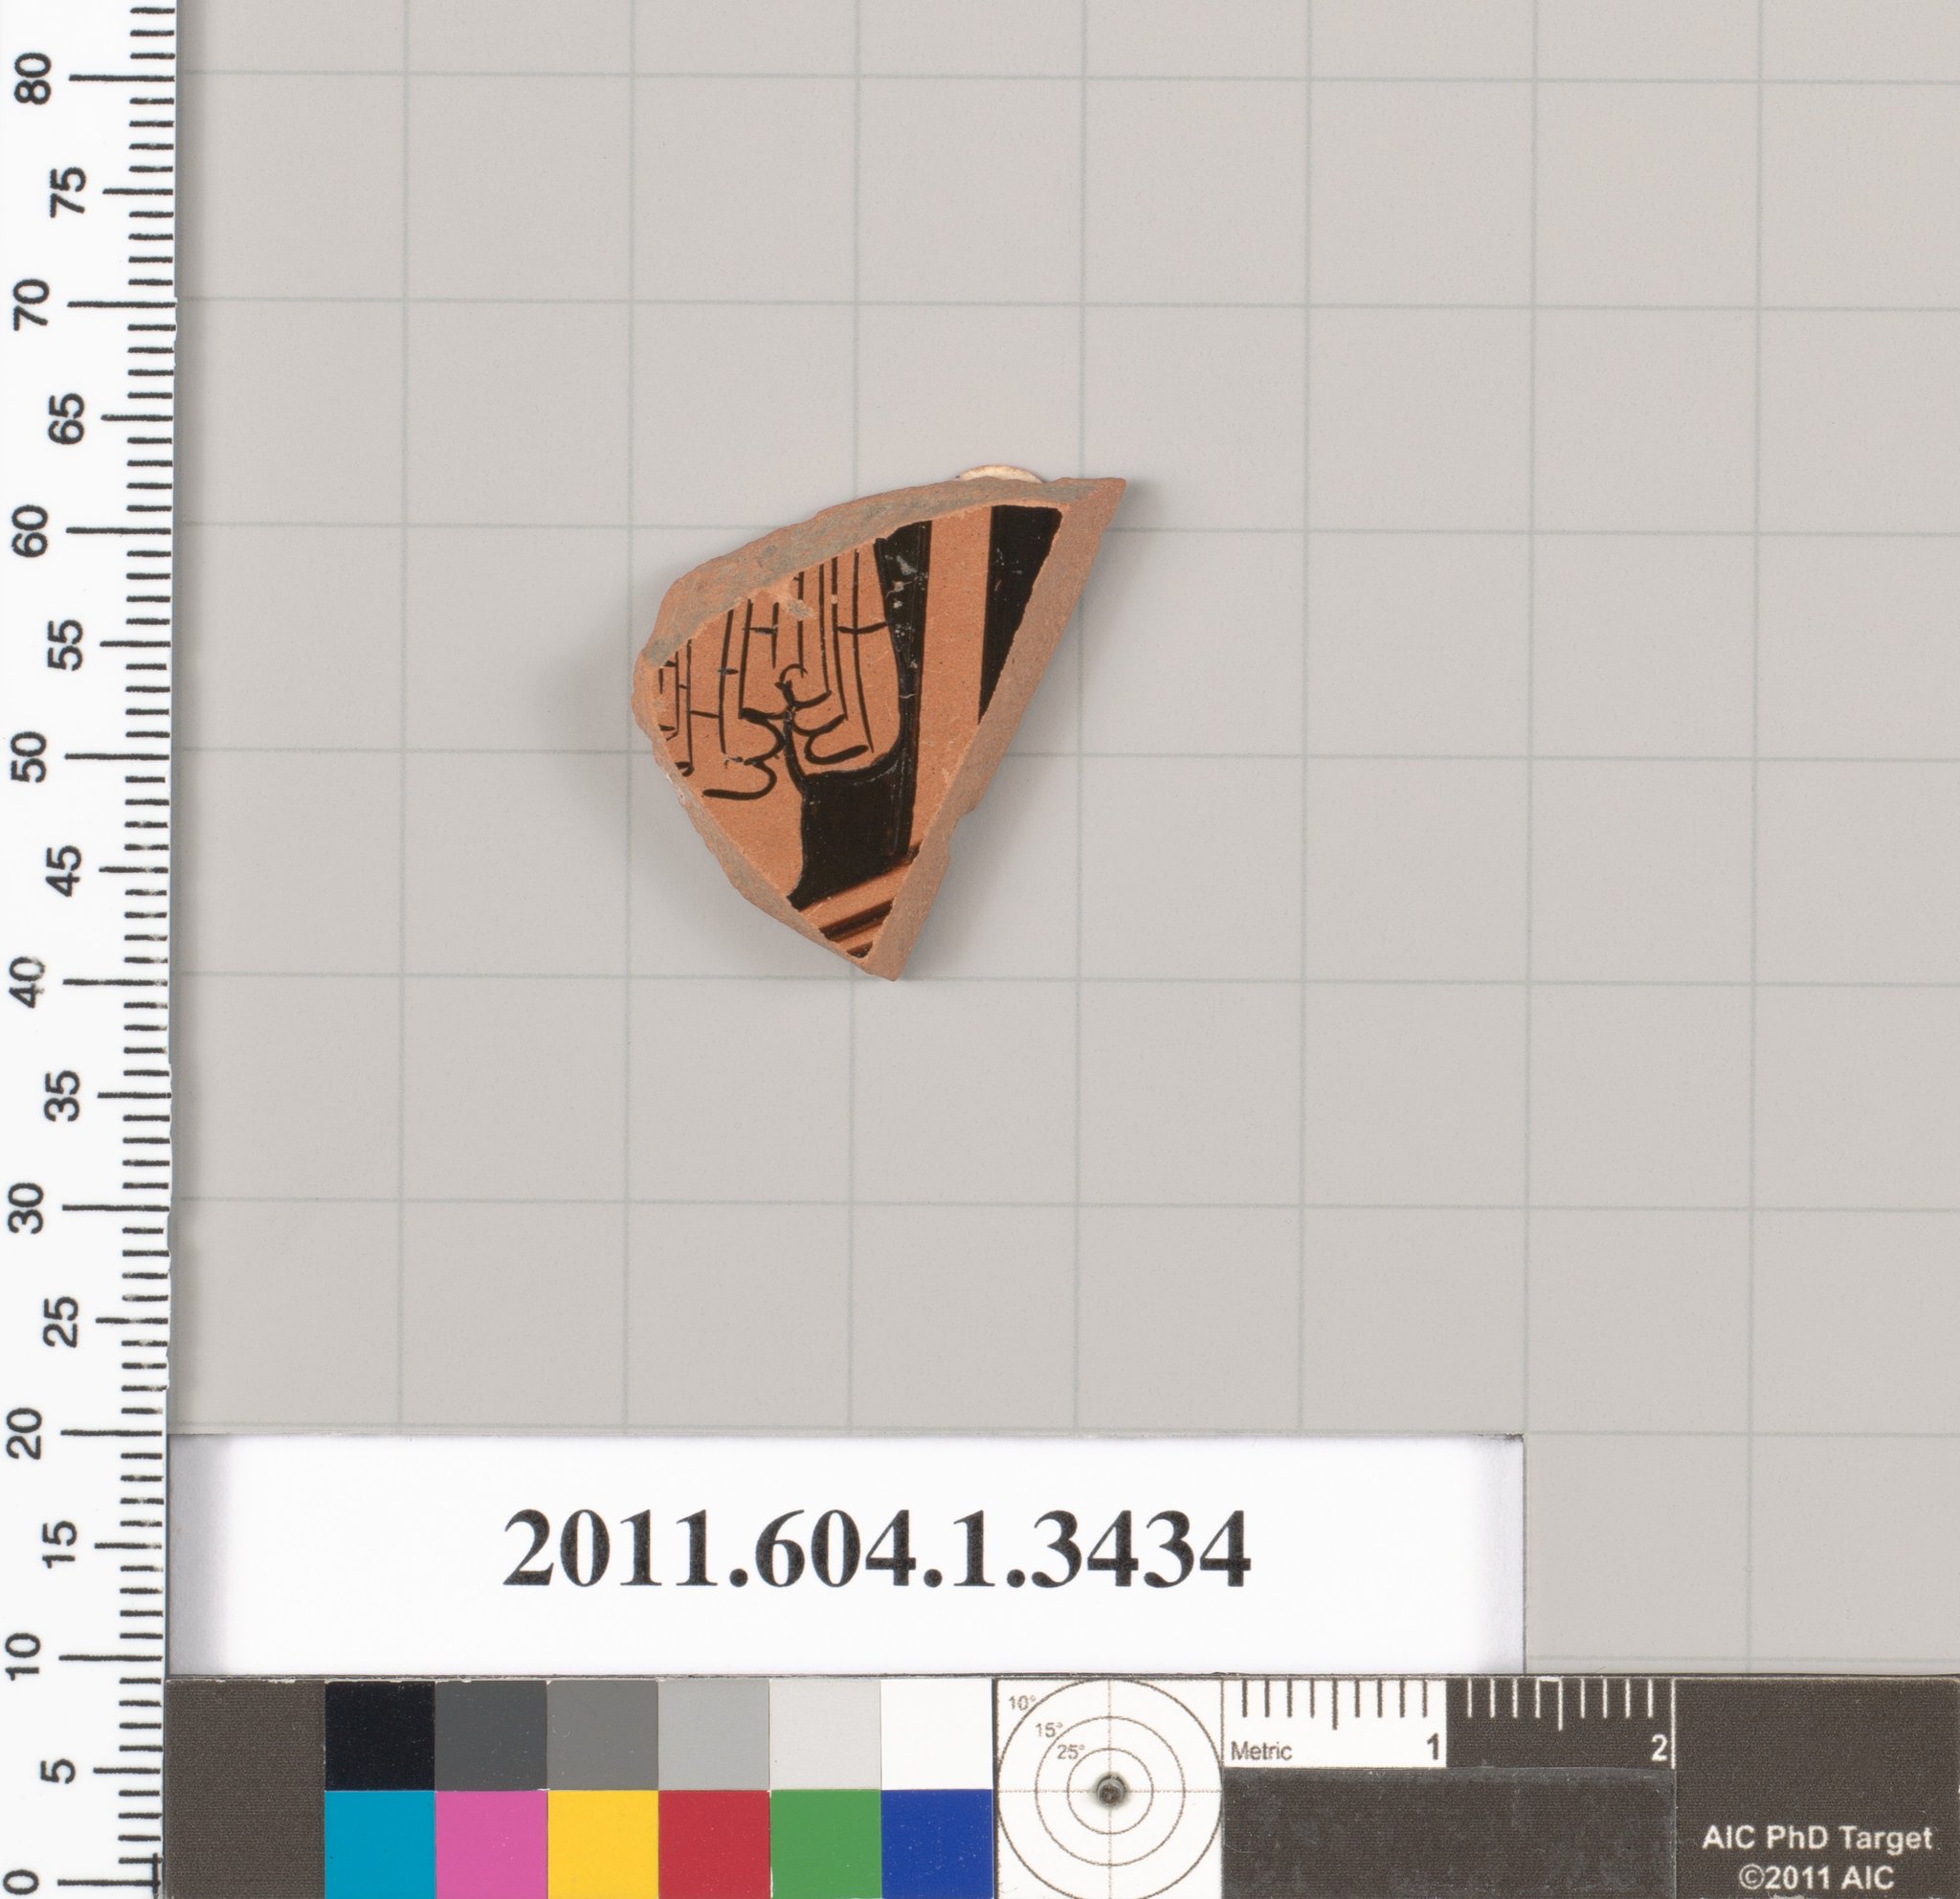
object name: kylix fragment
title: Terracotta fragment of a kylix (drinking cup)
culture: greek, attic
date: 490-480 BCE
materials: terracotta